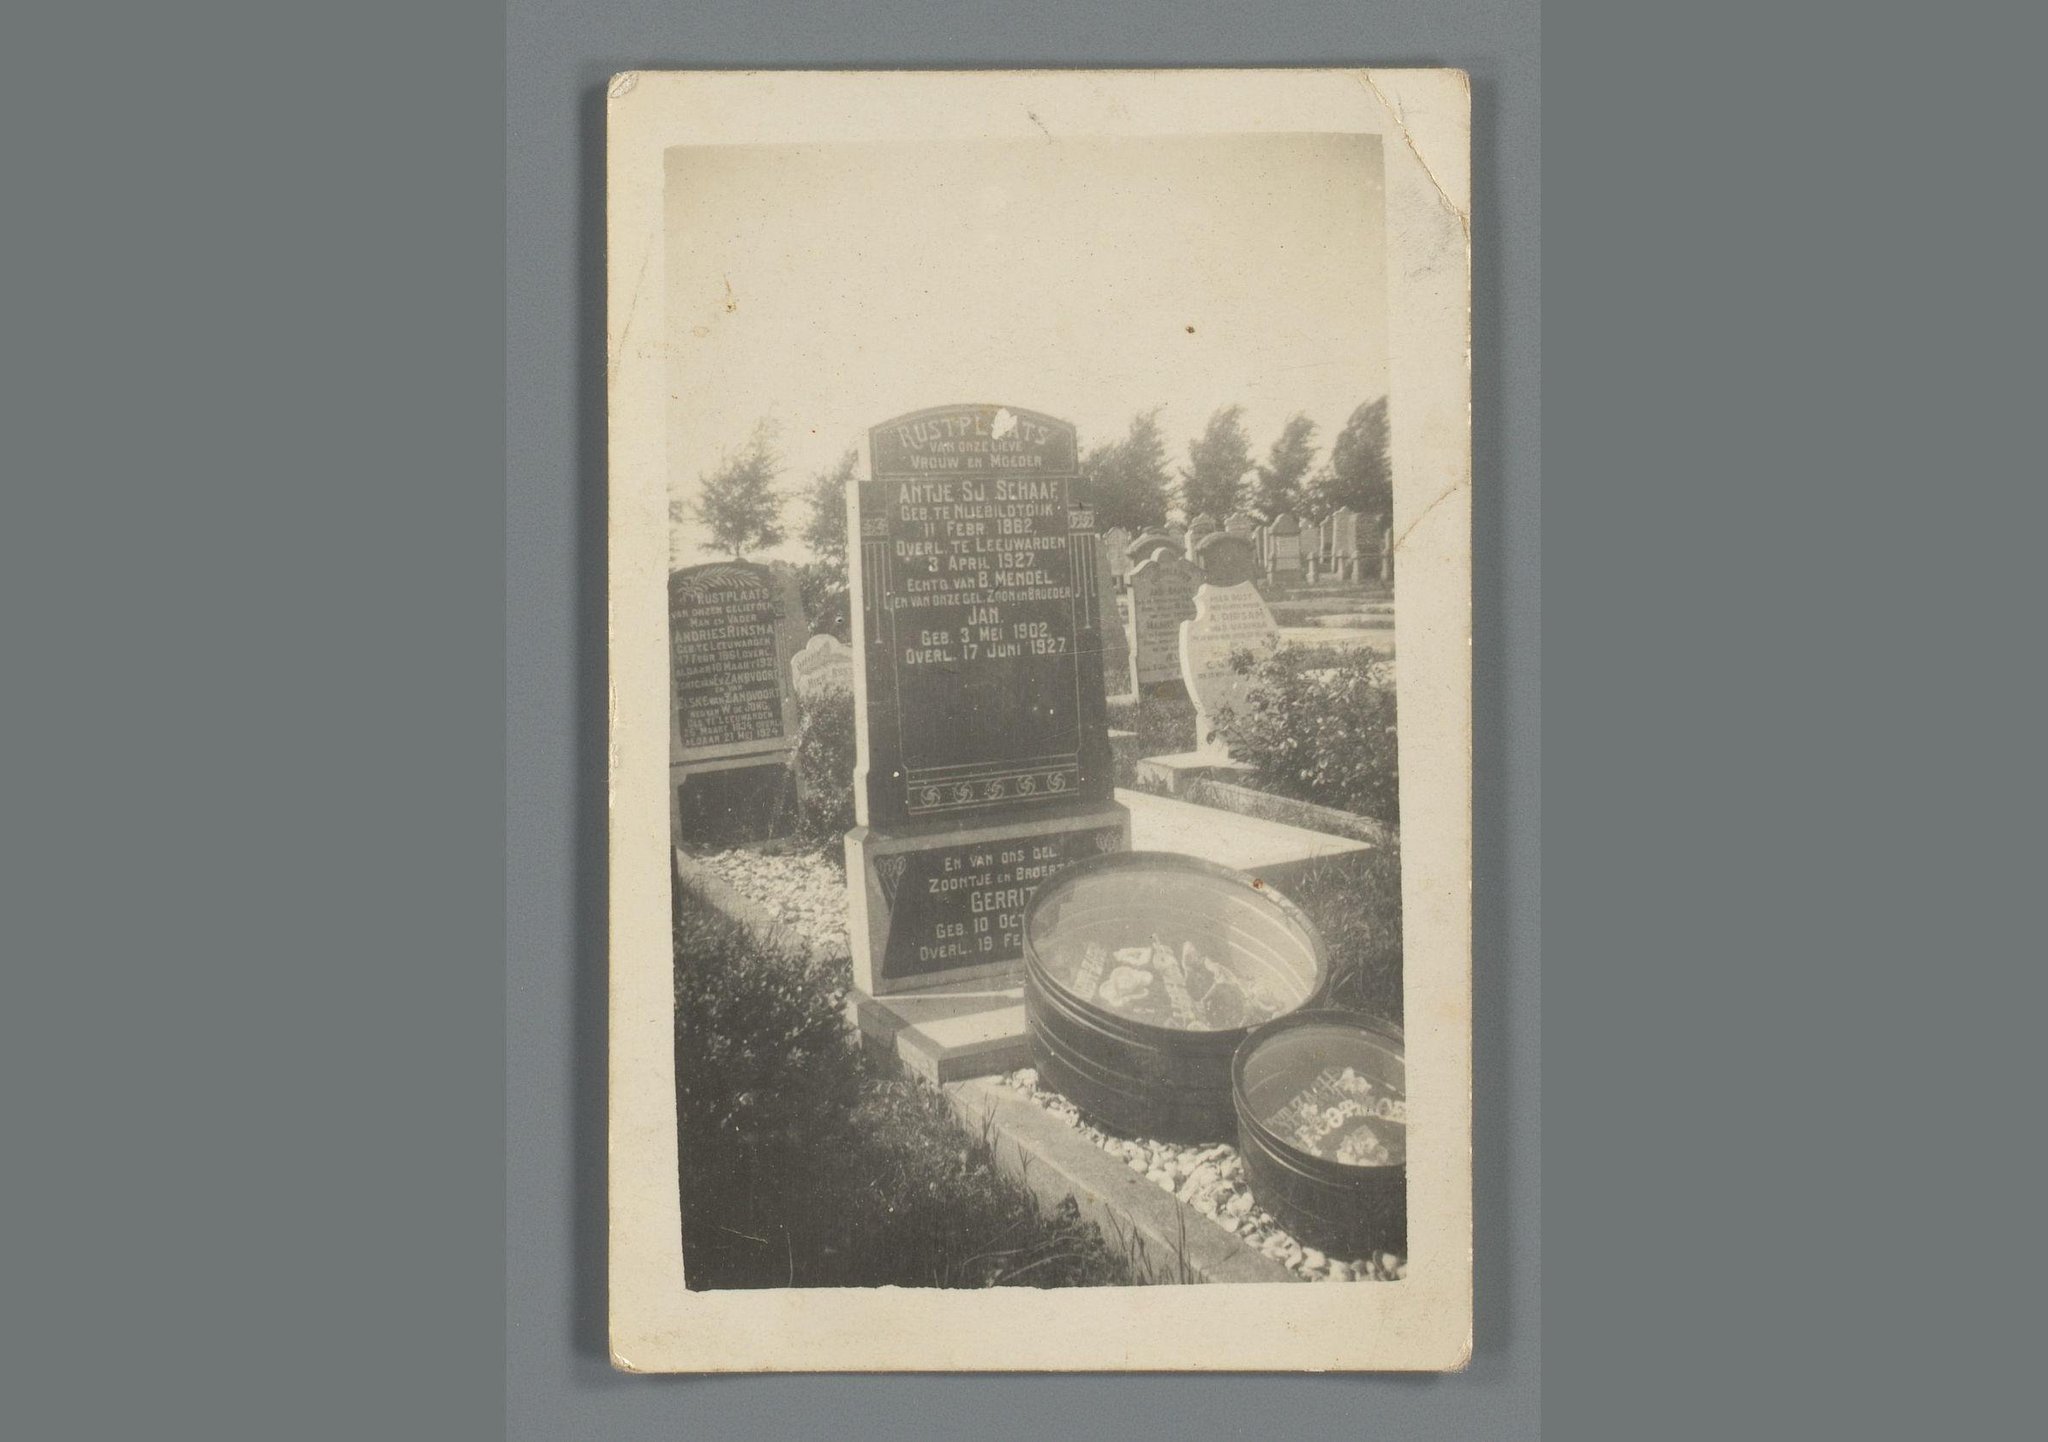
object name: photograph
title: Graf van Antje Schaaf en Jan Mendel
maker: Anonymous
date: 1927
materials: paper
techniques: gelatin silver print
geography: leeuwarden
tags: grave, tomb